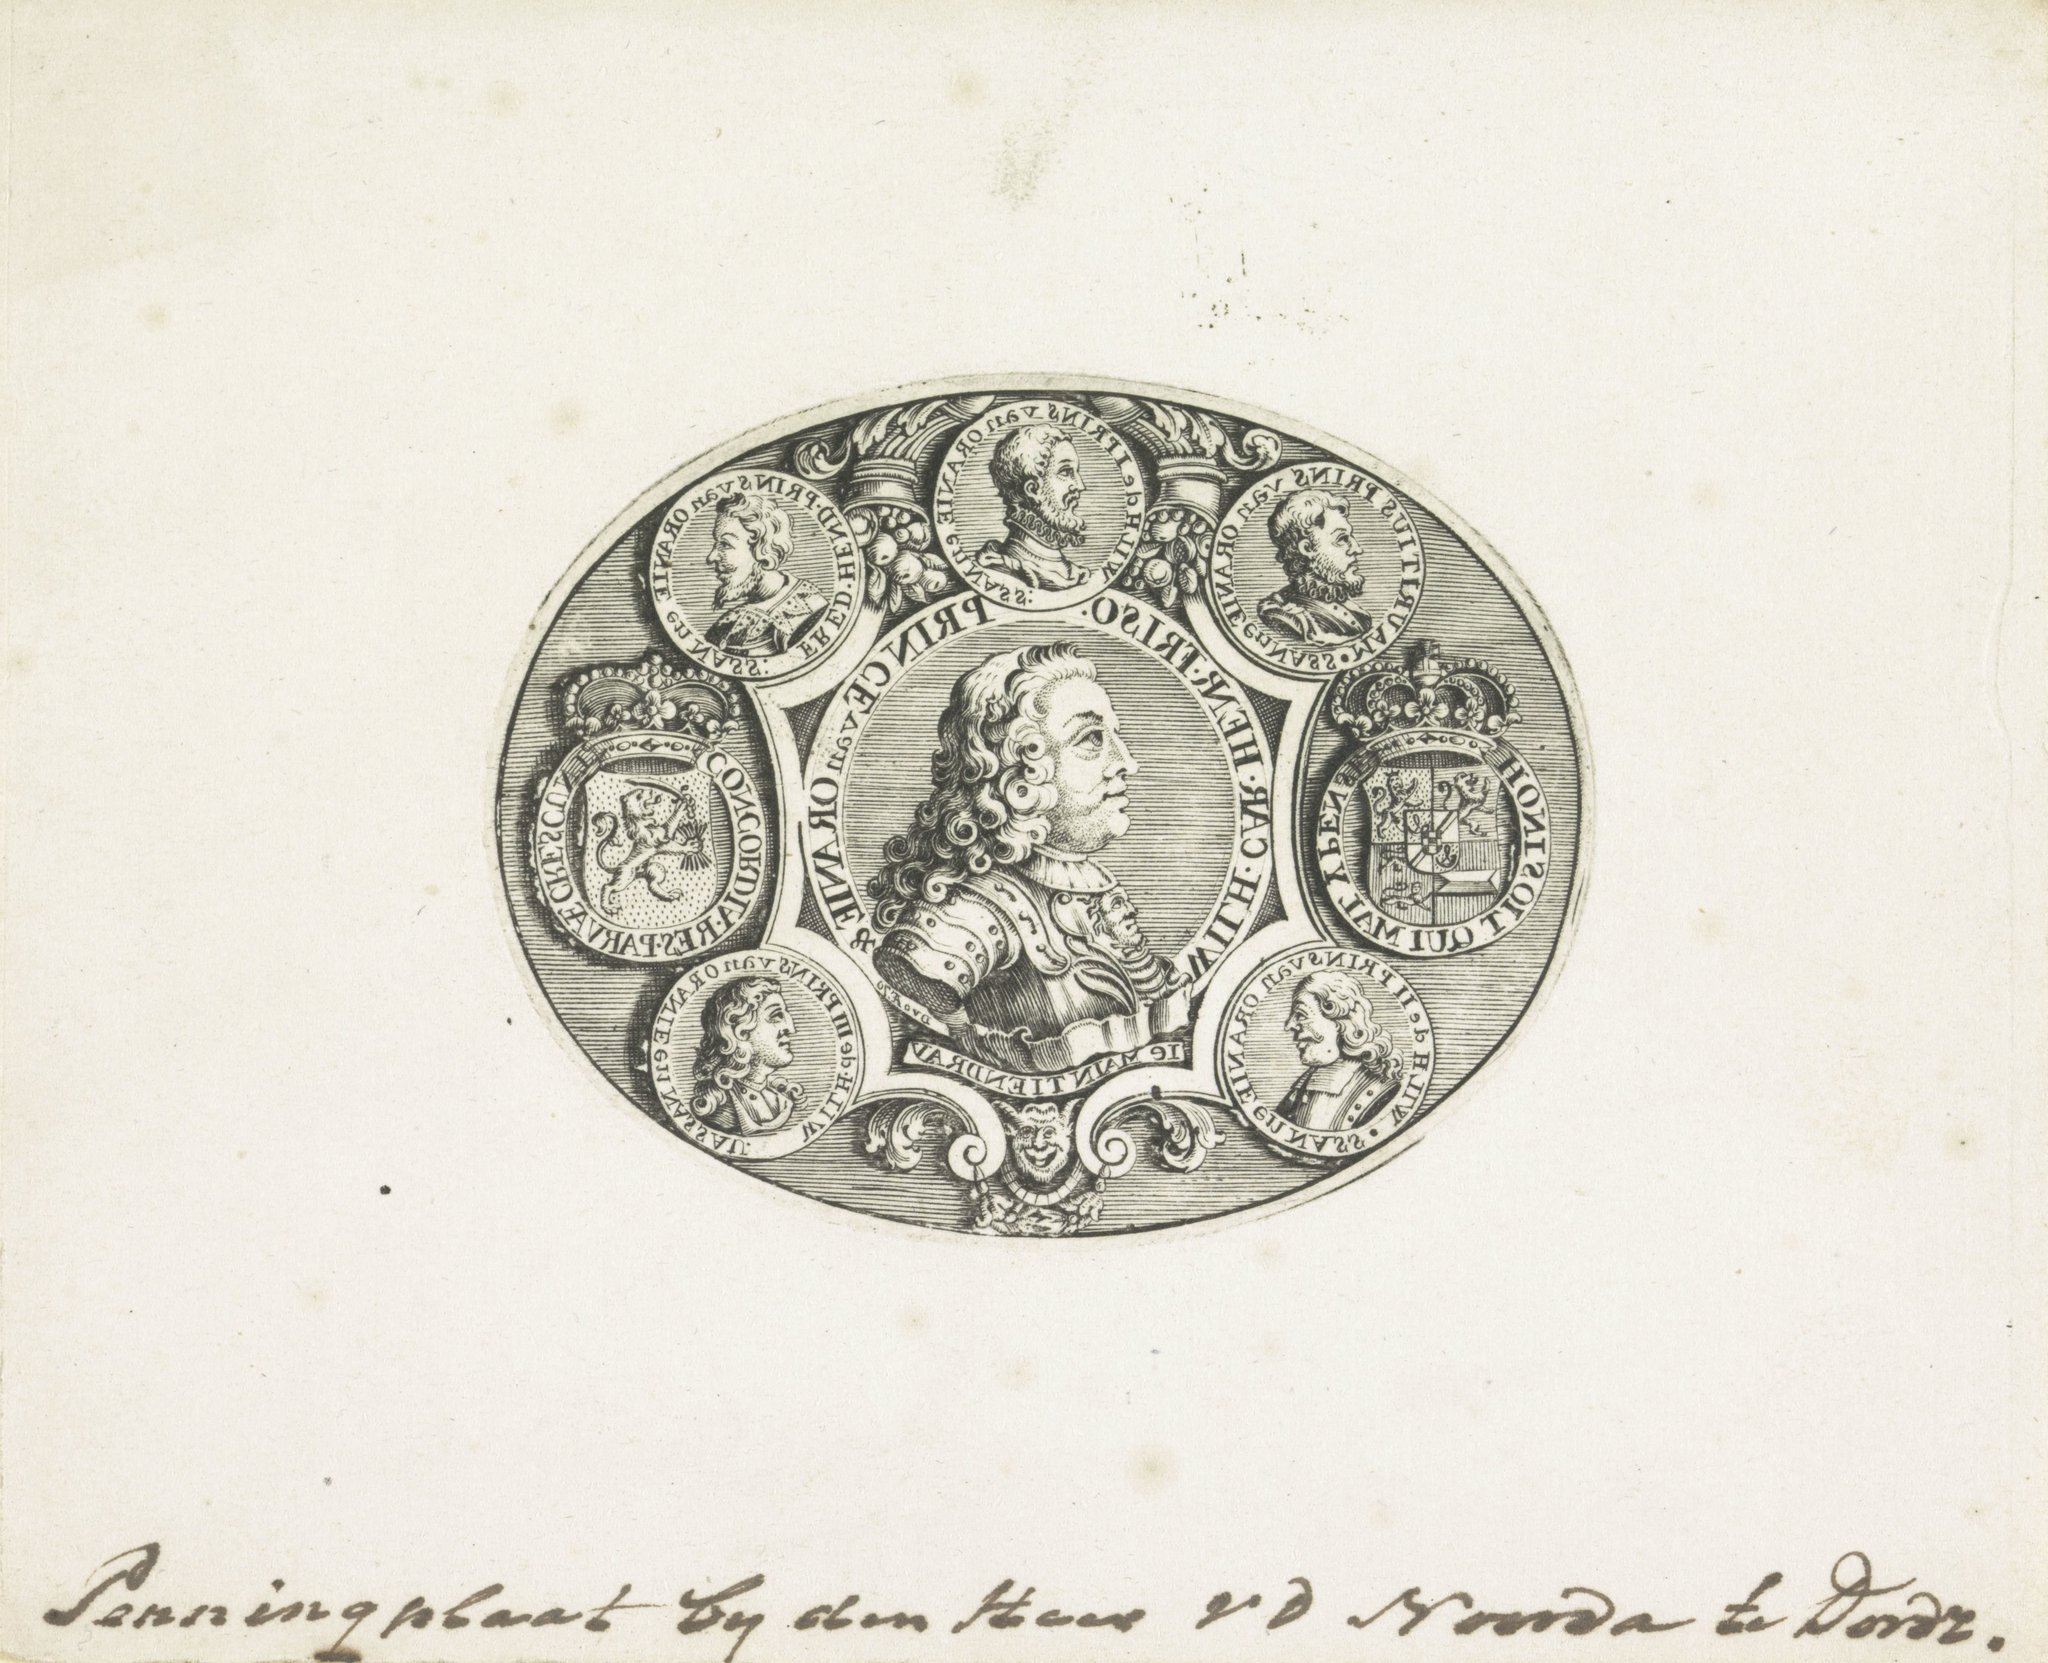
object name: print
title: Portret van Willem IV, prins van Oranje-Nassau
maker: Anonymous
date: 1747-1799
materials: paper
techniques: engraving, etching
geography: low countries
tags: william iii (prince of orange and king of england, scotland, and ireland), delft, the hague, frederick henry (prince of orange), william ii (prince of orange), william i (prince of orange), maurice (prince of orange), willem iv (prins van oranje-nassau), knighthood order (garter) - insignia of a knighthood order, e.g.: badge, chain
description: Portret van Willem IV in een cirkel met randschrift. Daaronder op een banderol zijn geslachtsspreuk. Geheel in een ovale omlijsting met zijn wapen met een kroon, gedecoreerd met de Kousenband en het devies van de Orde van de Kousenband, en portretten van Willem I, Maurits, Frederik Hendrik, Willem II en Willem III, elk in een cirkel met randschrift. In spiegelbeeld.